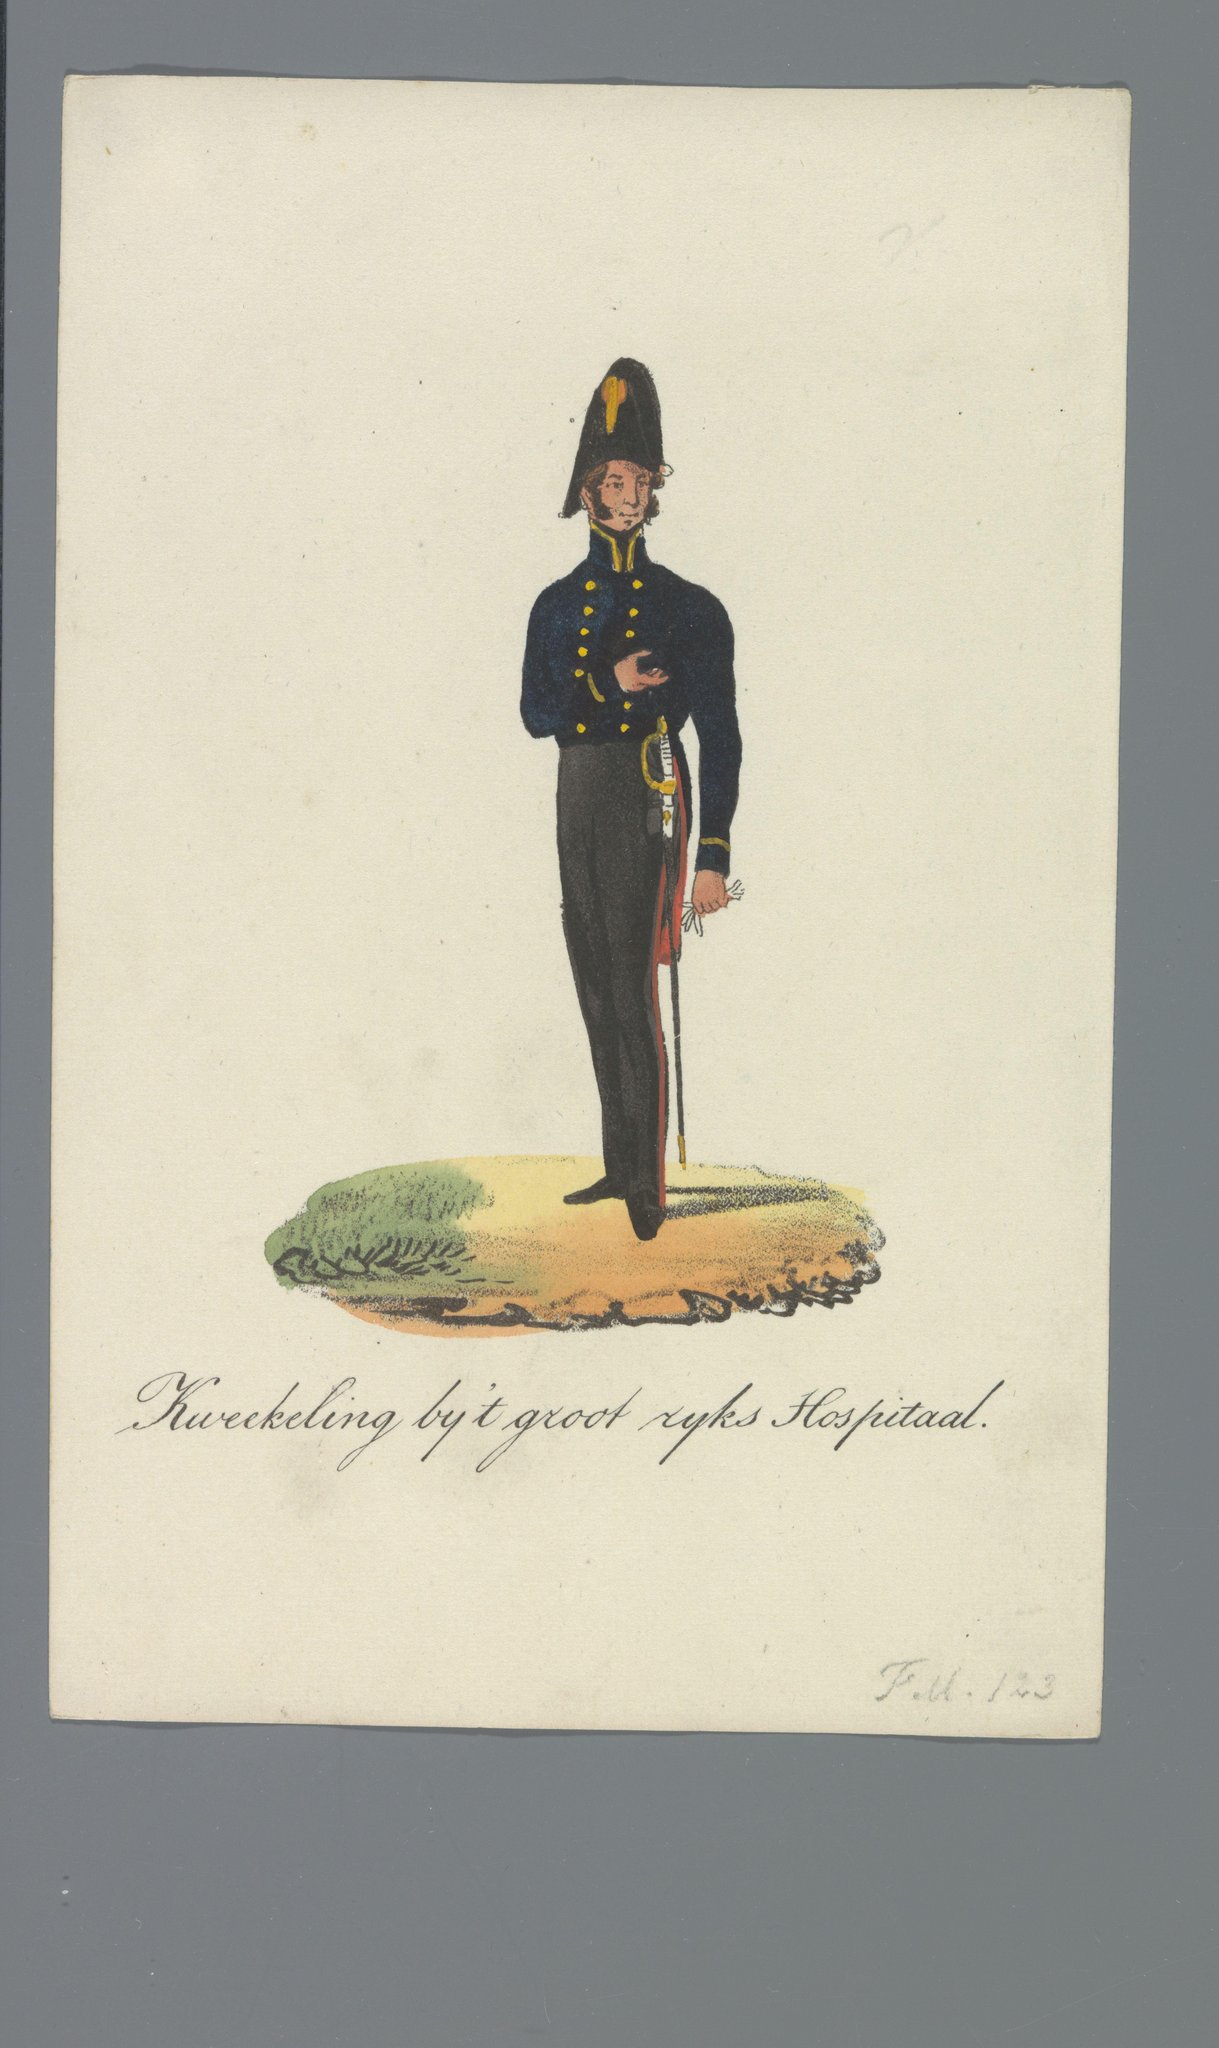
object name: costume print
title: Nederlandse militaire uniformen in de jaren 1830-1832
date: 1835-1850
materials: paper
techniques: hand coloring, lithograph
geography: netherlands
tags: (military) uniforms, clothes, costume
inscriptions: collector's mark: Lugt 2228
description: Een kwekeling bij het Groot Rijks Hospitaal of Militair Hospitaal te Utrecht, te voet. Onderdeel van een serie van 157 losse bladen met Nederlandse militaire uniformen in de jaren 1830-1832.